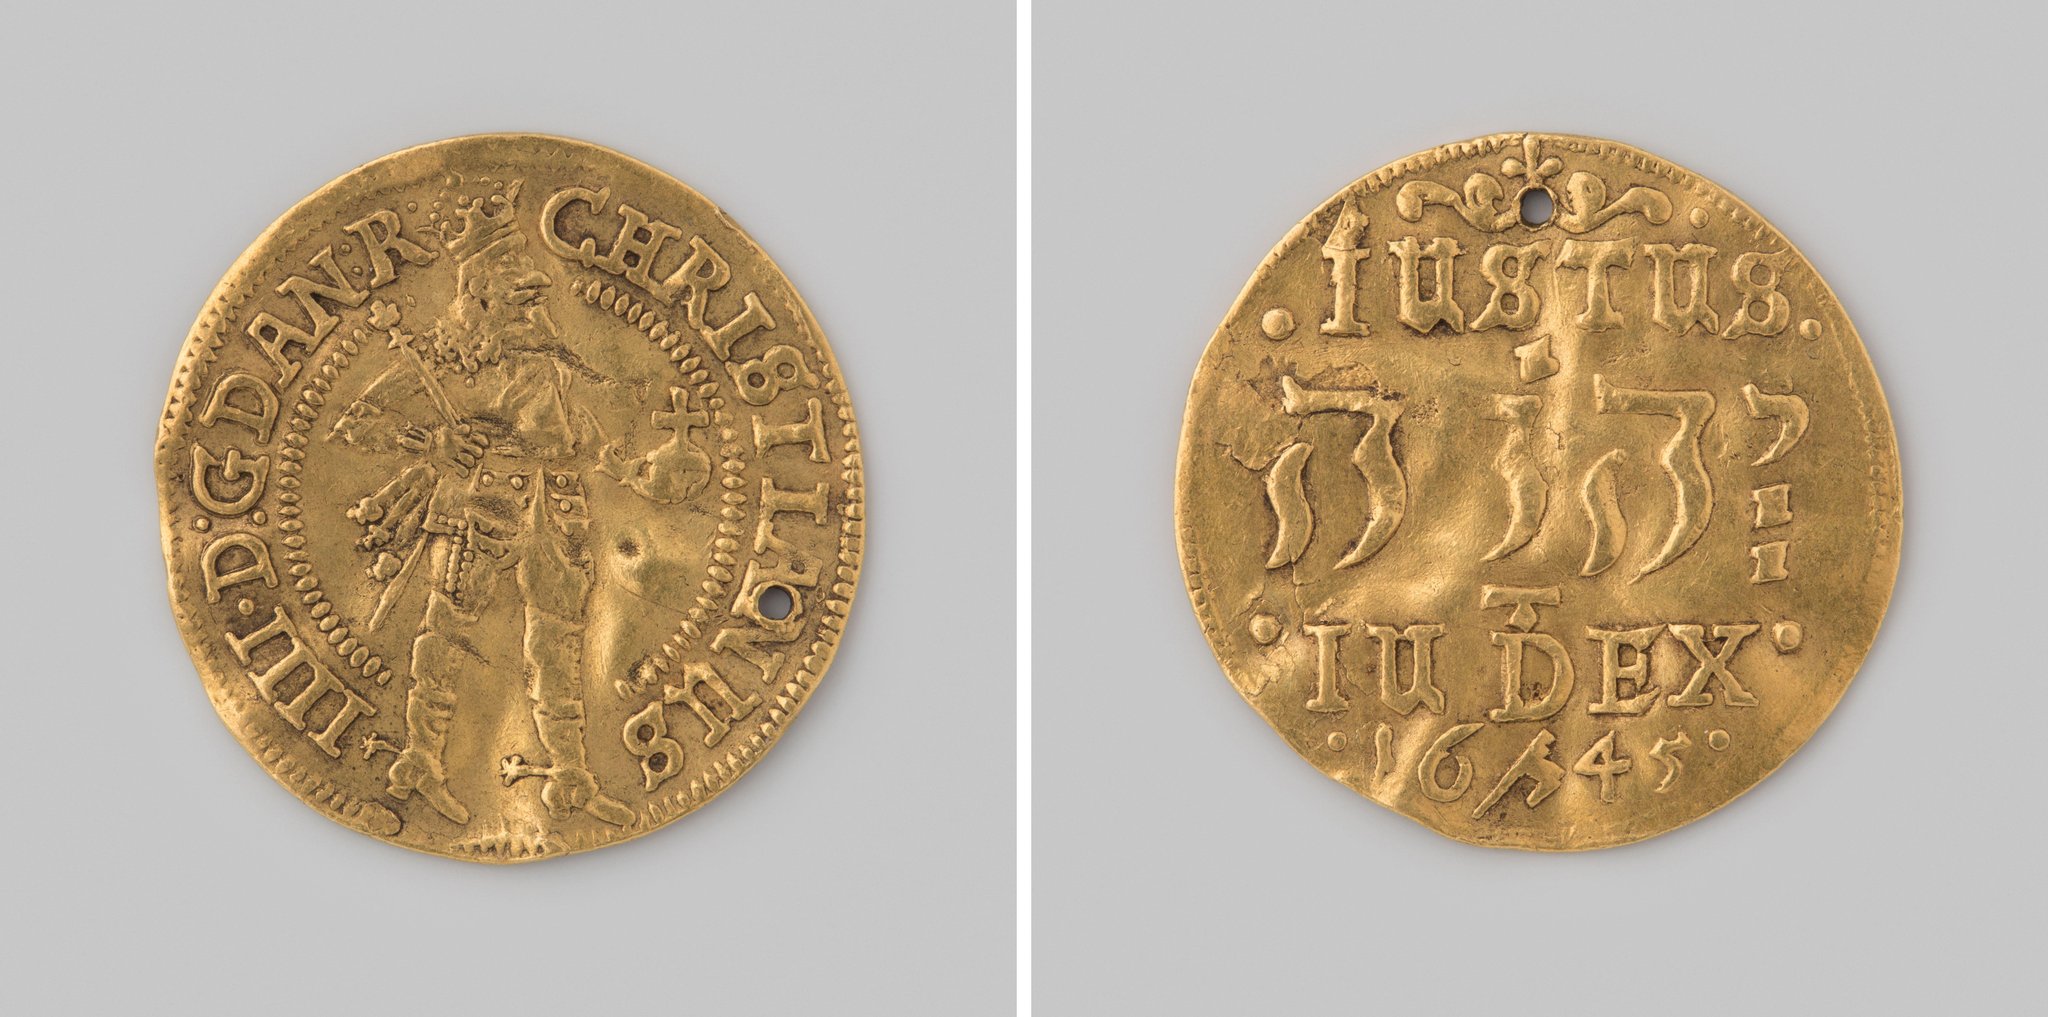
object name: ducat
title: Denemarken, Christiaan IV, dukaat, 1645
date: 1645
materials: gold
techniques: striking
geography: copenhagen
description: Gouden munt. Voorzijde: staande koning naar rechts, in rechterhand scepter, in linkerhand rijksappel met kruis. Keerzijde: onder versiering drie-regelig opschrft, middelste regels in het Hebreeuws. Jaartal onderaan. Gladde rand. Gaatje in muntplaatje.